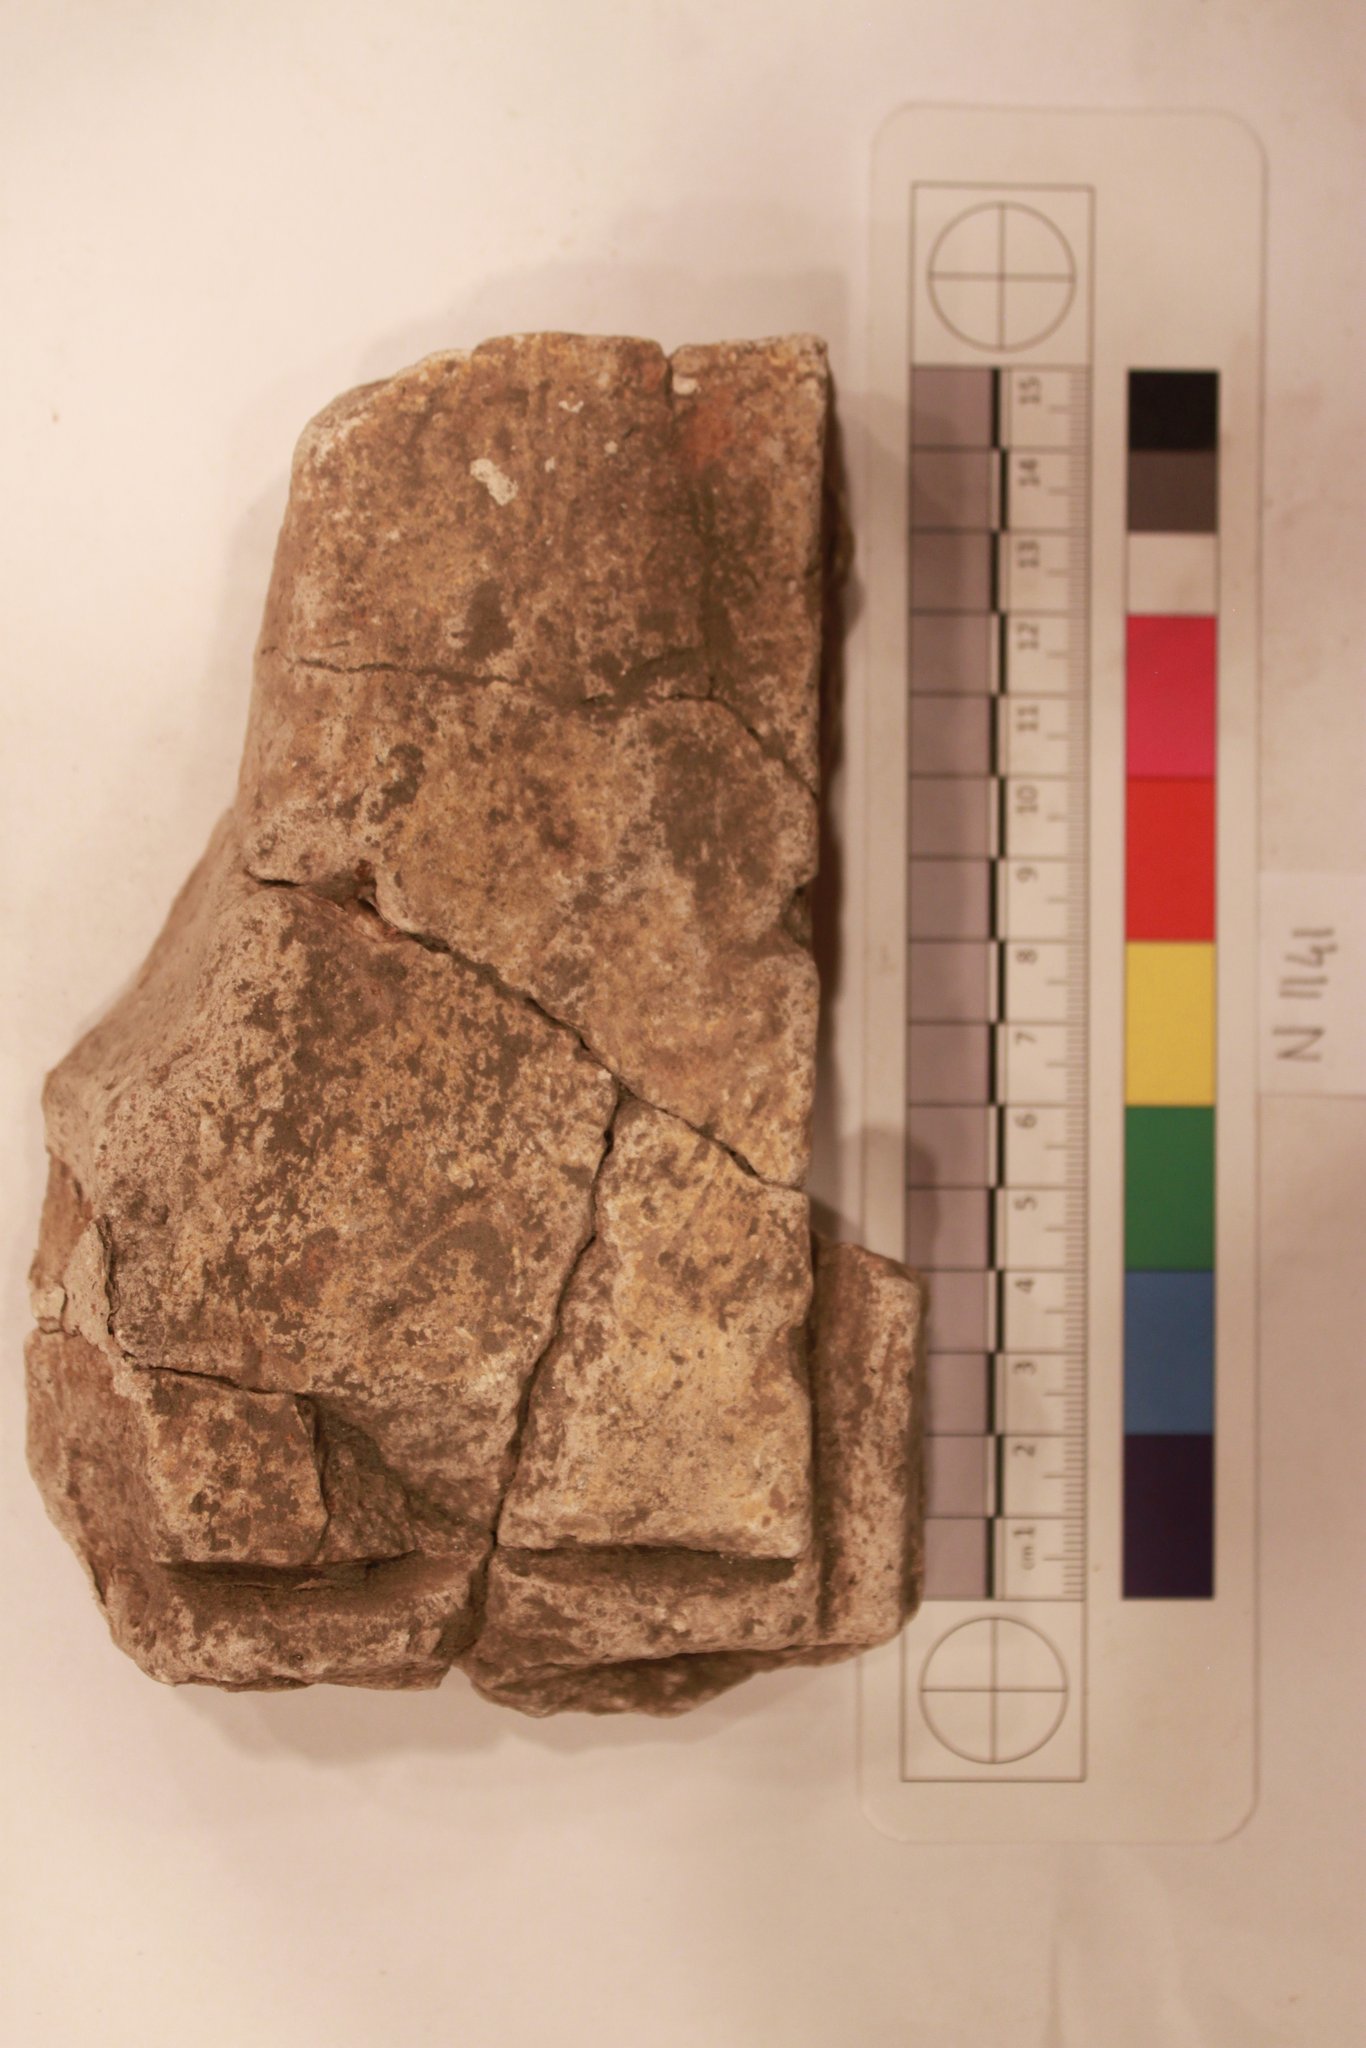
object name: fragment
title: Stucco Fragment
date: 701-1200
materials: plaster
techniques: carving, painting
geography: iran